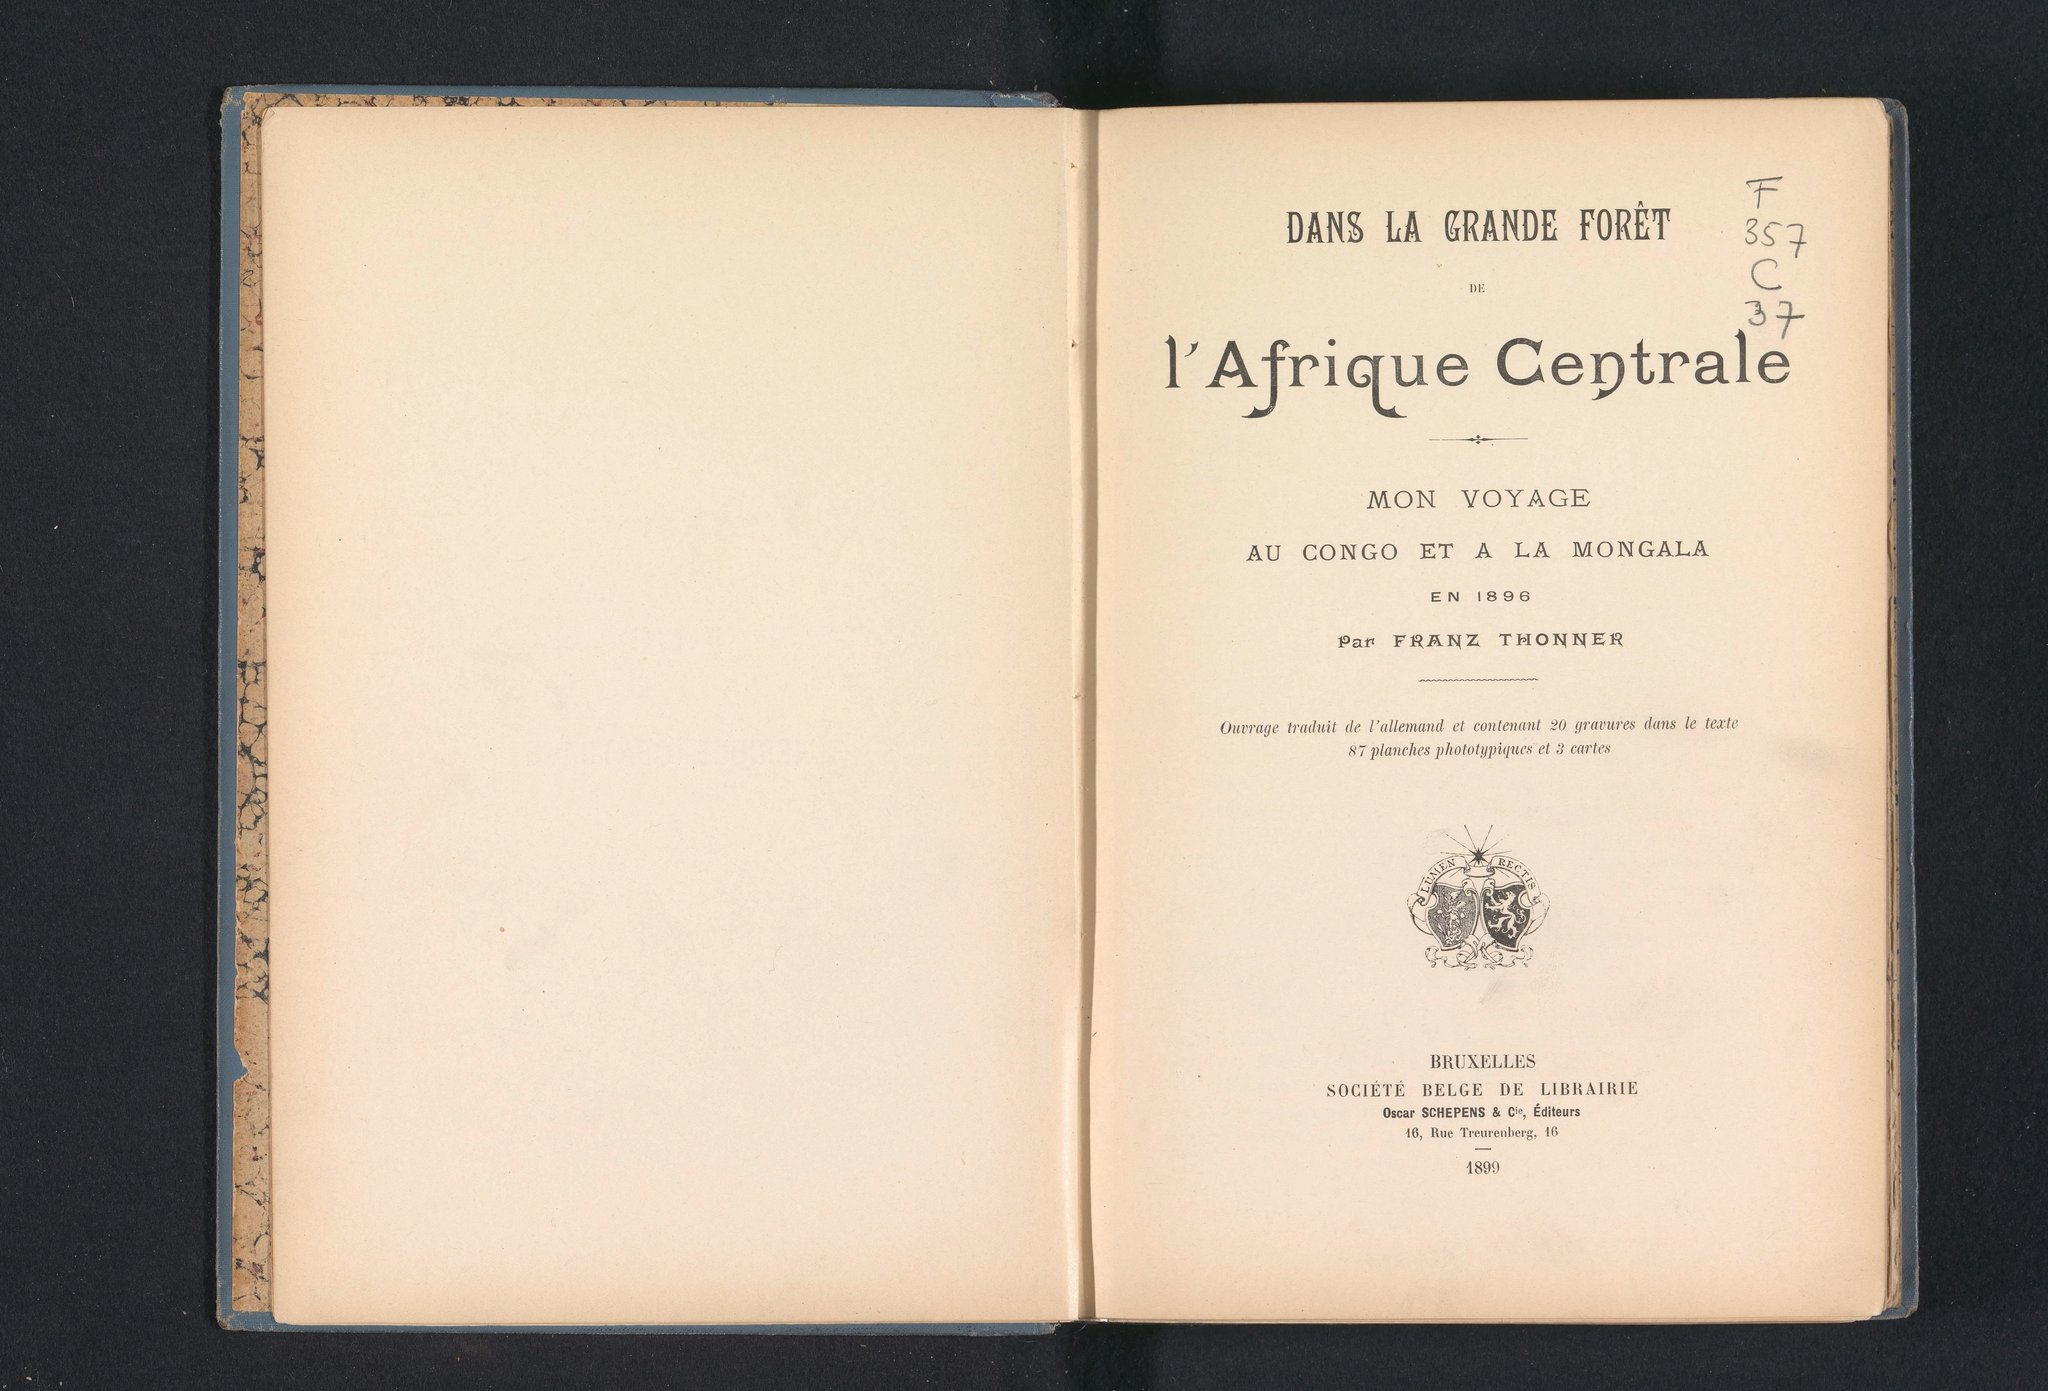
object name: book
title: Dans la Grande forêt de l'Afrique Centrale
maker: franz thonner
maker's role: botanicus, ontdekkingsreiziger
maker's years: 1863-1928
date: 1899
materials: cardboard, linen, paper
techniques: photograph, lithograph, printing, marbling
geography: brussels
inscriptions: inscription: ‘À Madame Henriette L 'Huillier hommage de Fr. Thonner’